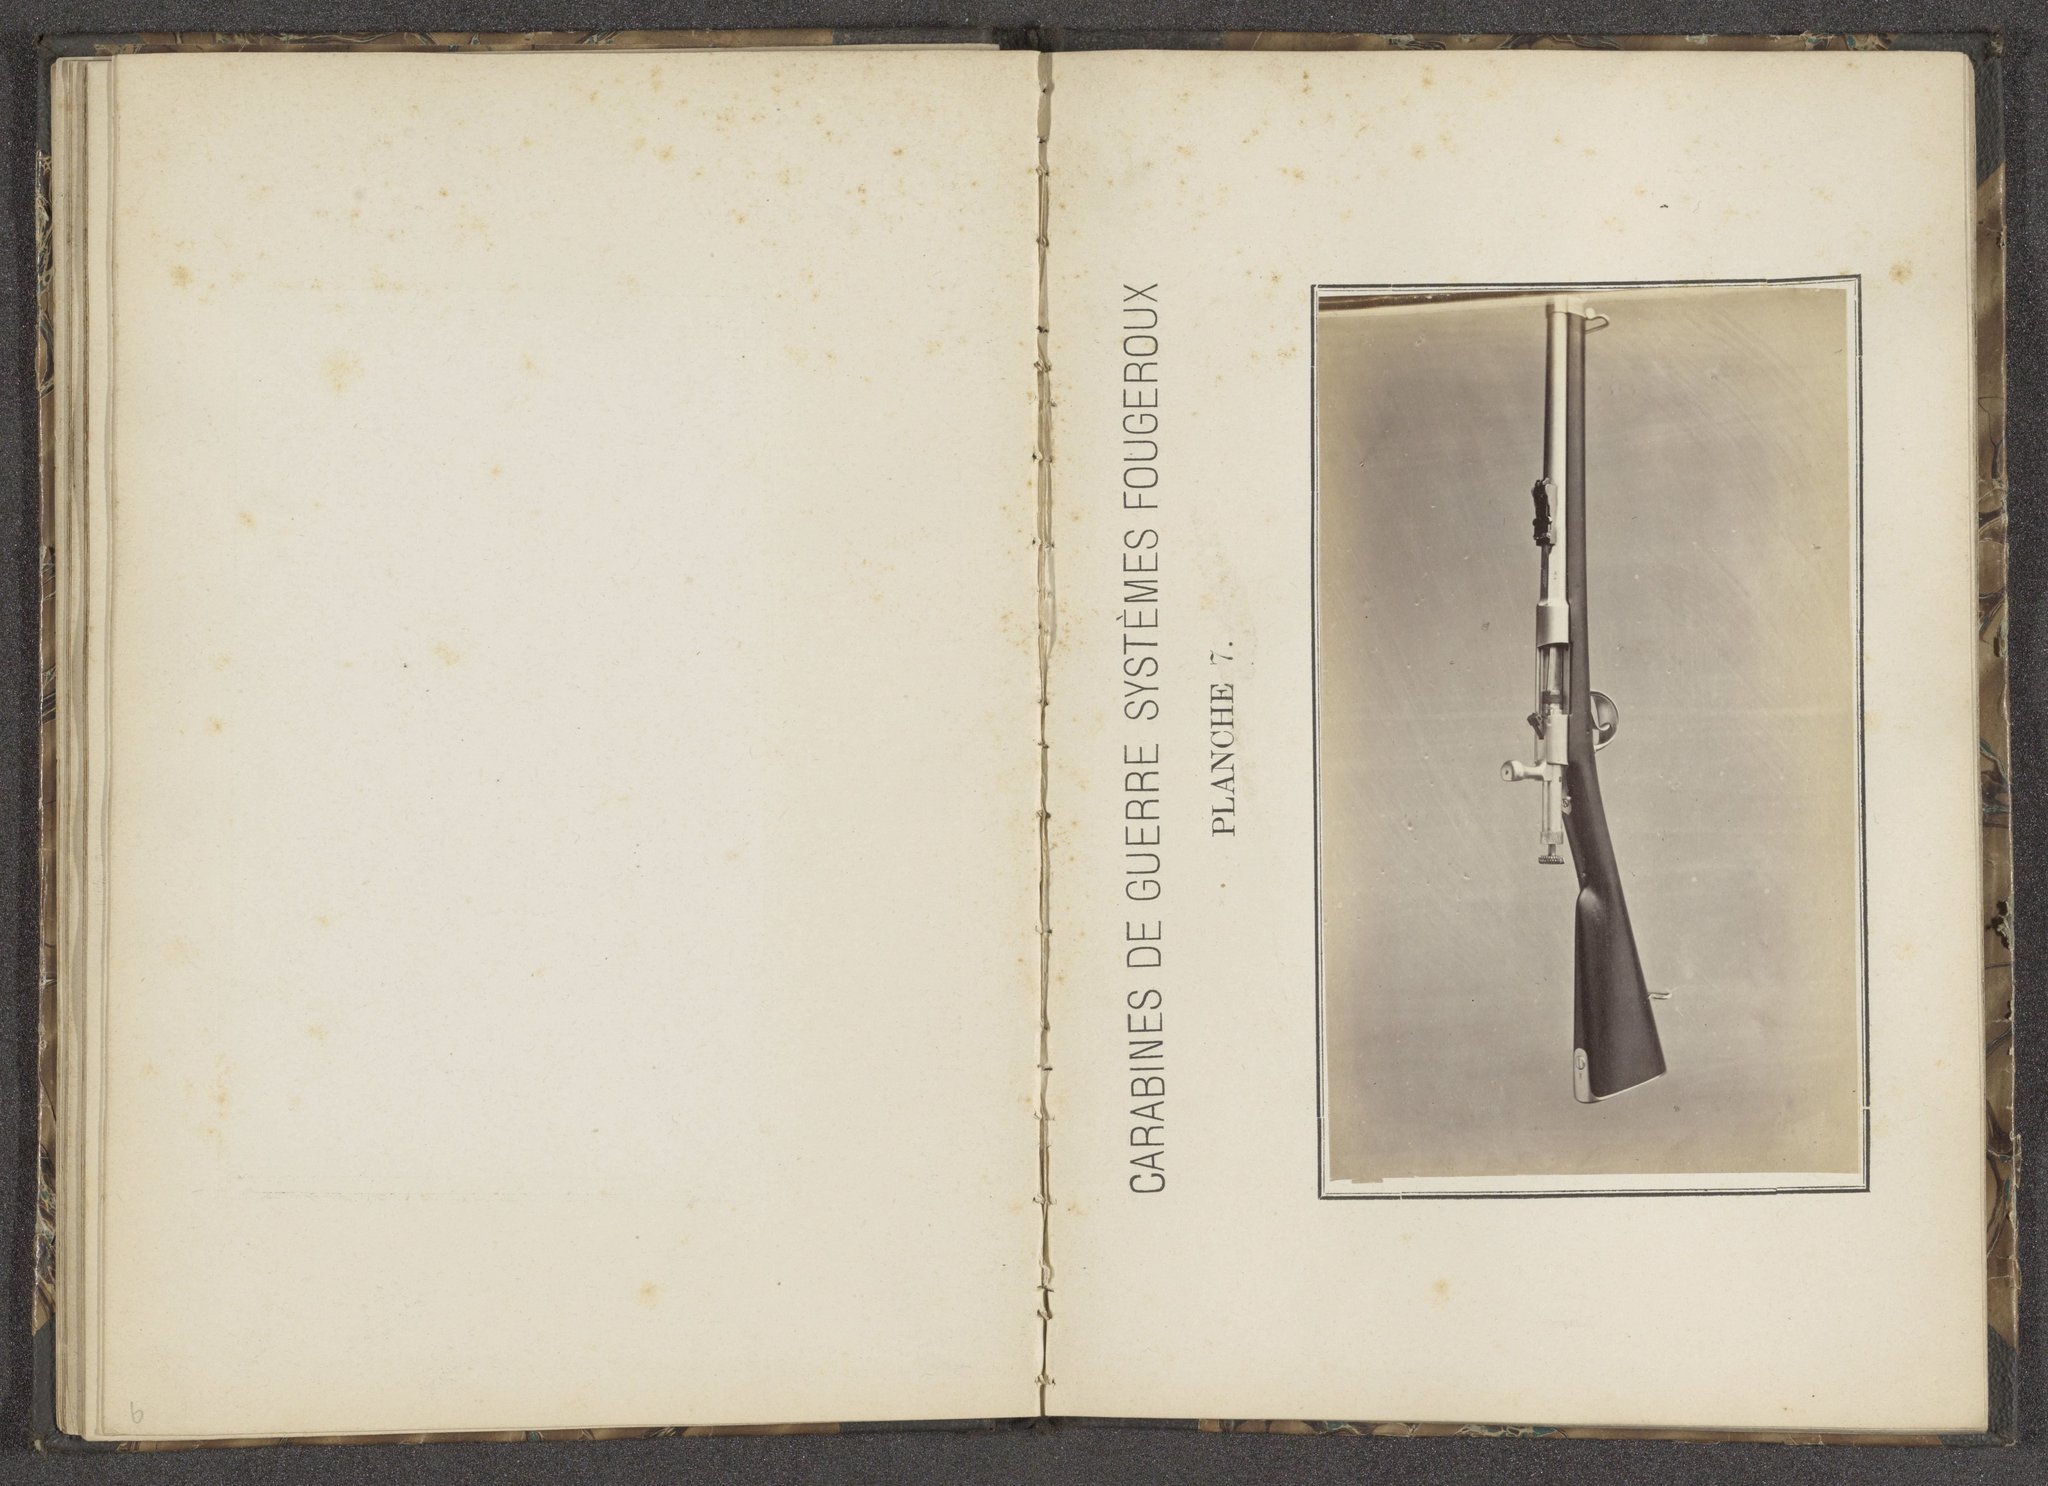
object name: page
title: Deel van een geweer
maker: edouard magis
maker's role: fotograaf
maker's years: 1828-1906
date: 1857-1867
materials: photographic support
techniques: albumen print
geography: liège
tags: firearms: rifle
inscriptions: number: ‘Planche 7.’, inscription: ‘Carabines de guerres systèmes Fougeroux’